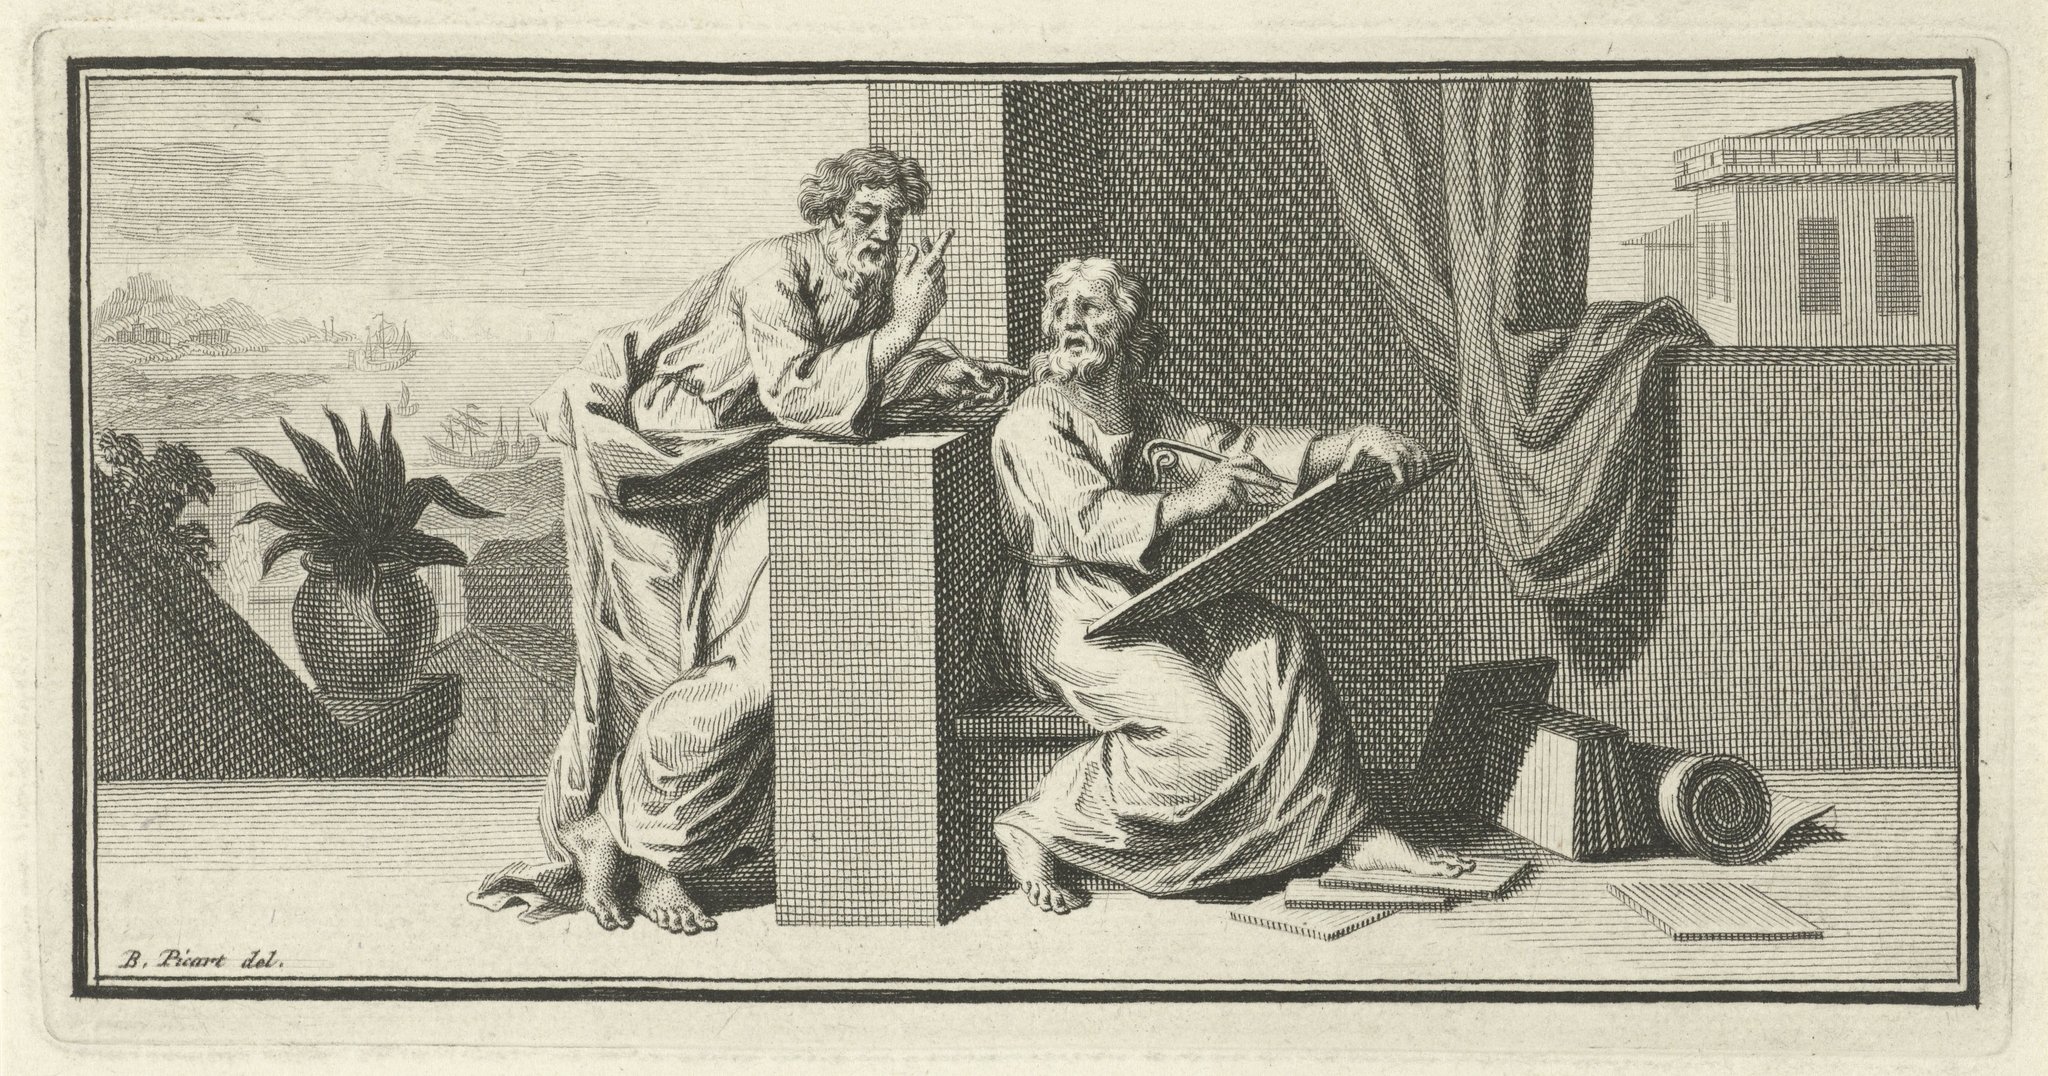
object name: print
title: Lucas schrijft zijn evangelie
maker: bernard picart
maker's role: draughtsman, print maker, publisher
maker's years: 1673-1733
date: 1709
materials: paper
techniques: engraving, etching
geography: paris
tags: the evangelists writing - ii - the evangelists without their symbols, the apostle paul of tarsus; possible attributes: book, scroll, sword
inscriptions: collector's mark: Lugt 2233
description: De evangelist Lucas schrijft zijn evangelie. Achter hem de apostel Paulus, die hij vergezelde op diens reizen naar Griekenland en Rome.